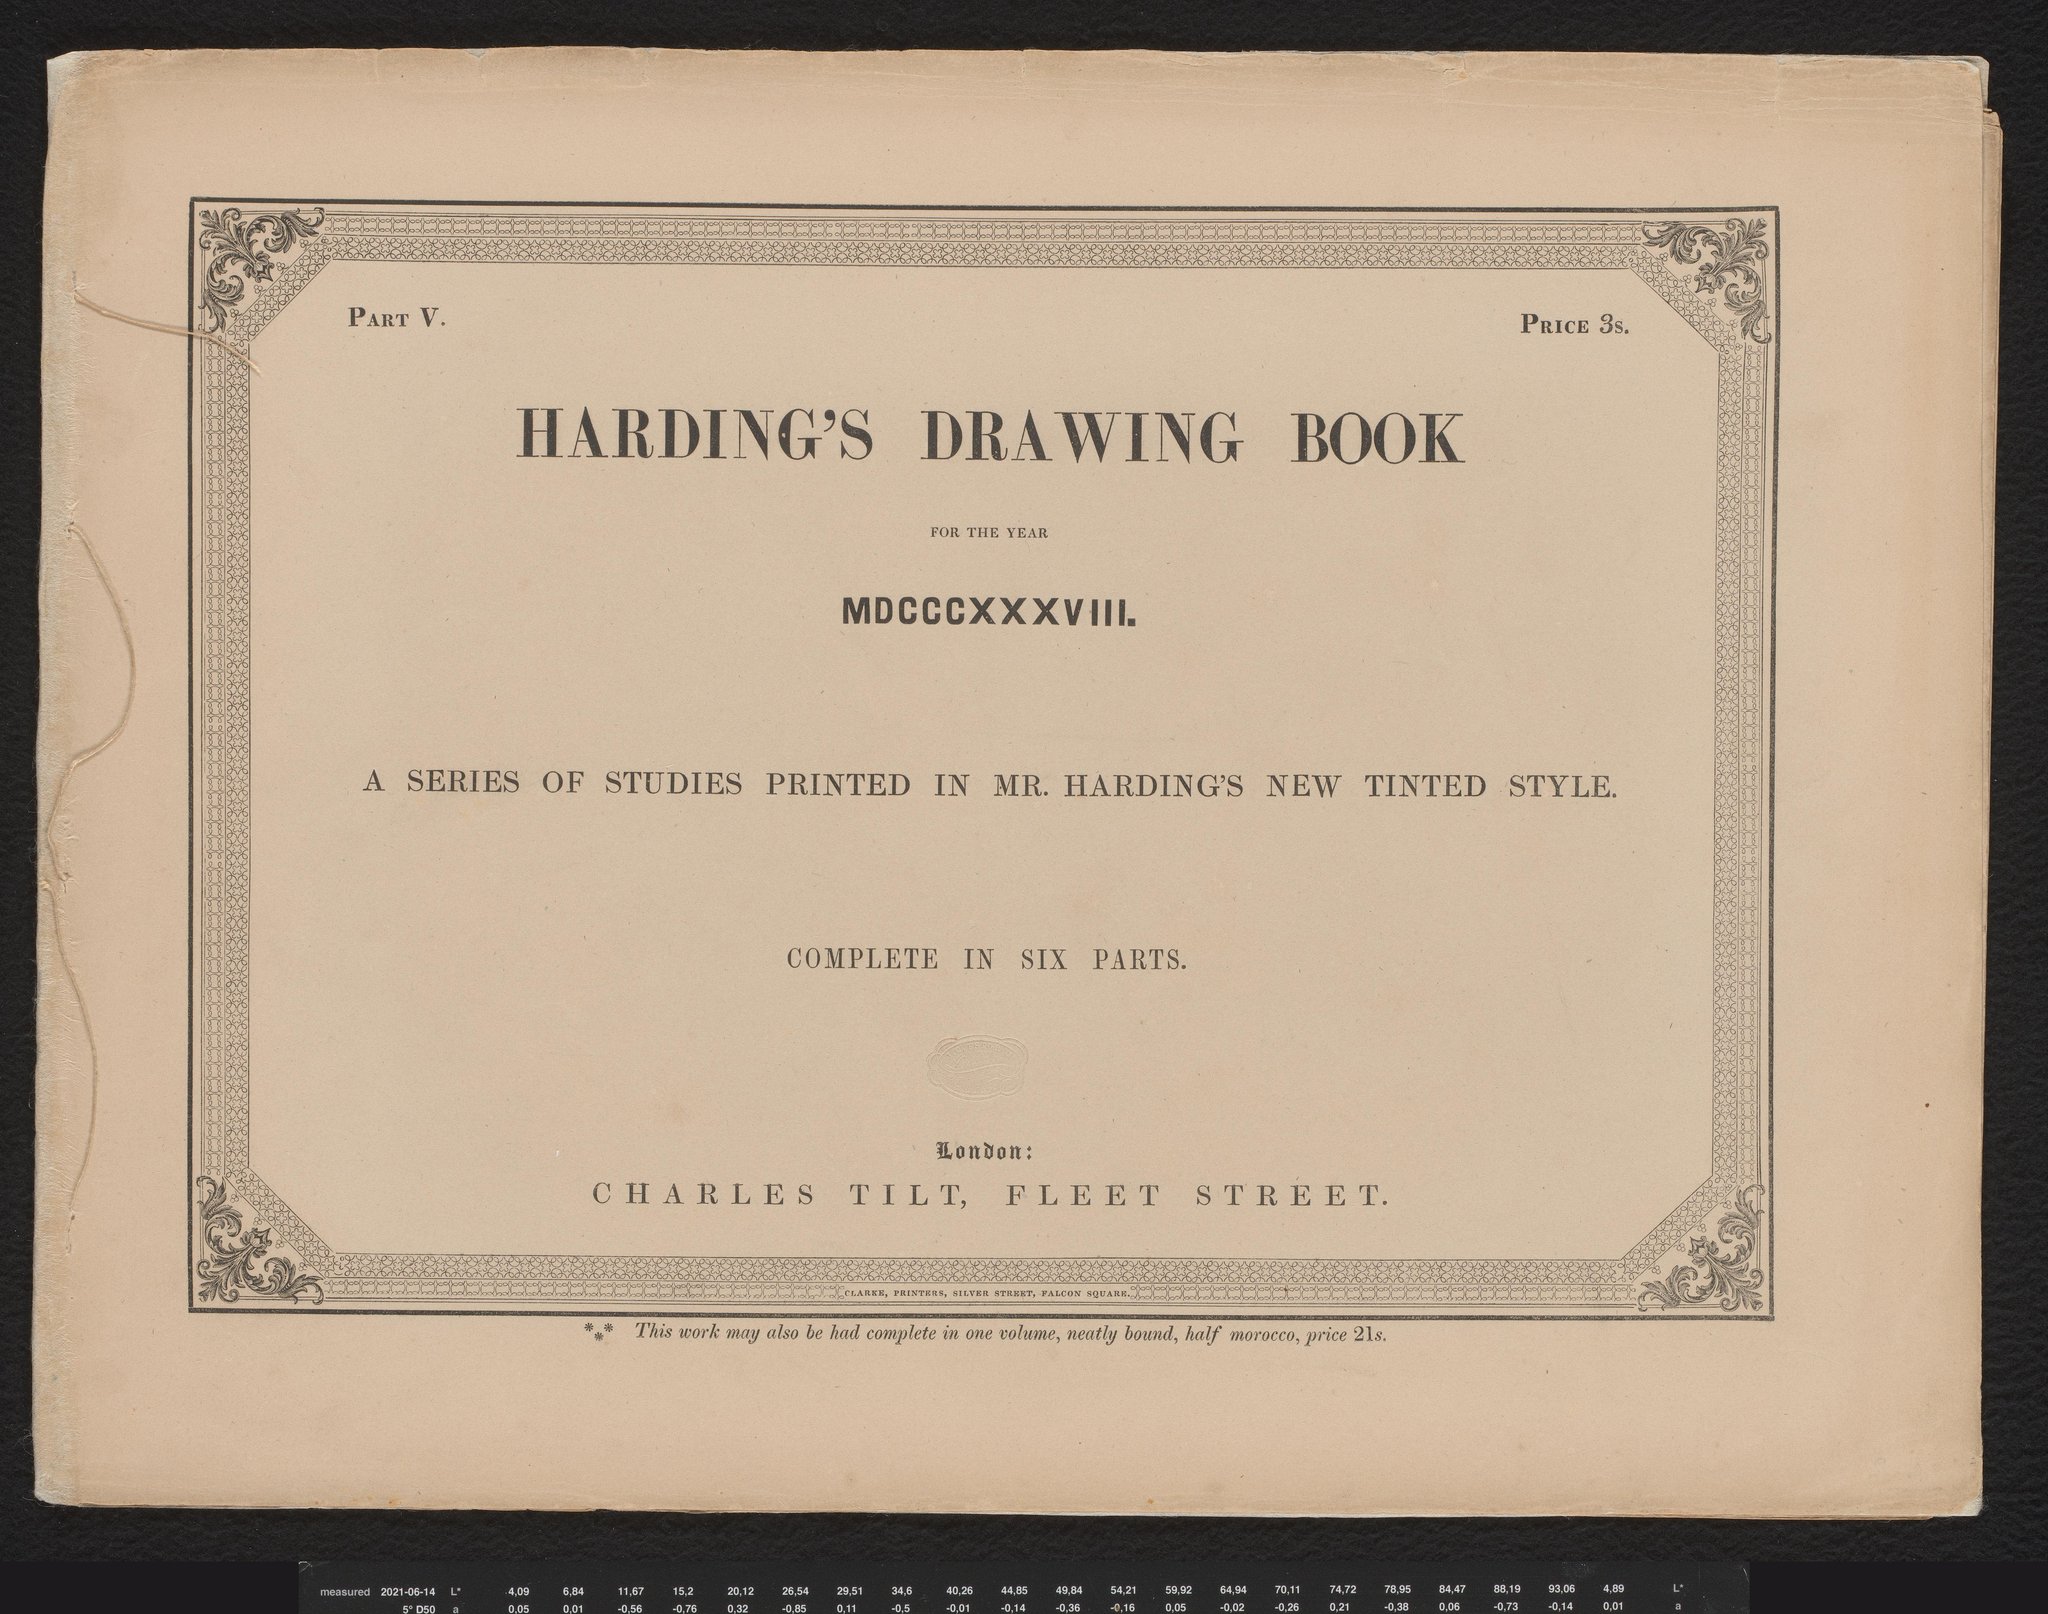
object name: wrapper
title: Tekenboek met werken van James Duffield Harding 1838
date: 1838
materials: paper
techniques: lithograph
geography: london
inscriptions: check stamp: ‘J.G. Estor Jr. Librairie a Magasin d'estampes a la Haye’, collector's mark: Lugt 2228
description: Uitgever Charles Tilt heeft verschillende series uitgegeven over het werk van James Duffield Harding. Deze serie 'Harding's drawing book for the year MDCCCXXXVIII', bestaat uit zes delen met elk vier lithografieën. Deze omslag is voor het vijfde deel.